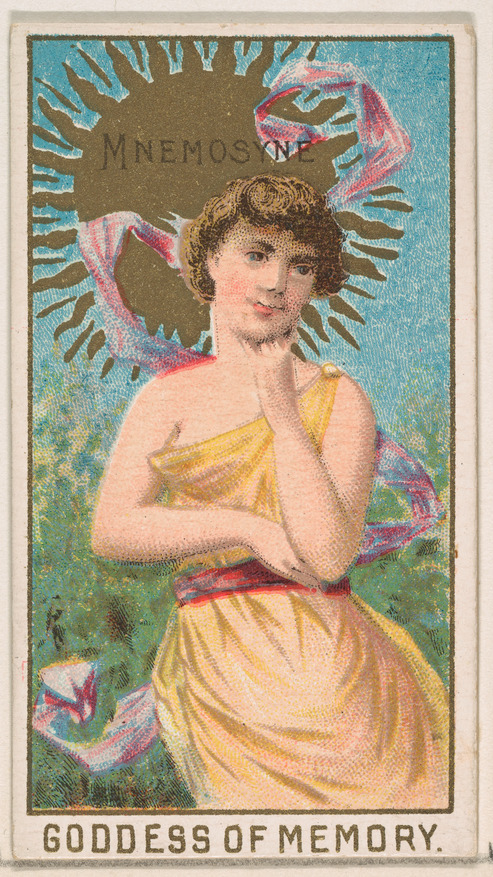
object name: print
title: Mnemosyne, Goddess of Memory, from the Goddesses of the Greeks and Romans series (N188) issued by Wm. S. Kimball & Co.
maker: william s. kimball & company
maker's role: publisher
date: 1889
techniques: color lithograph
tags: goddess